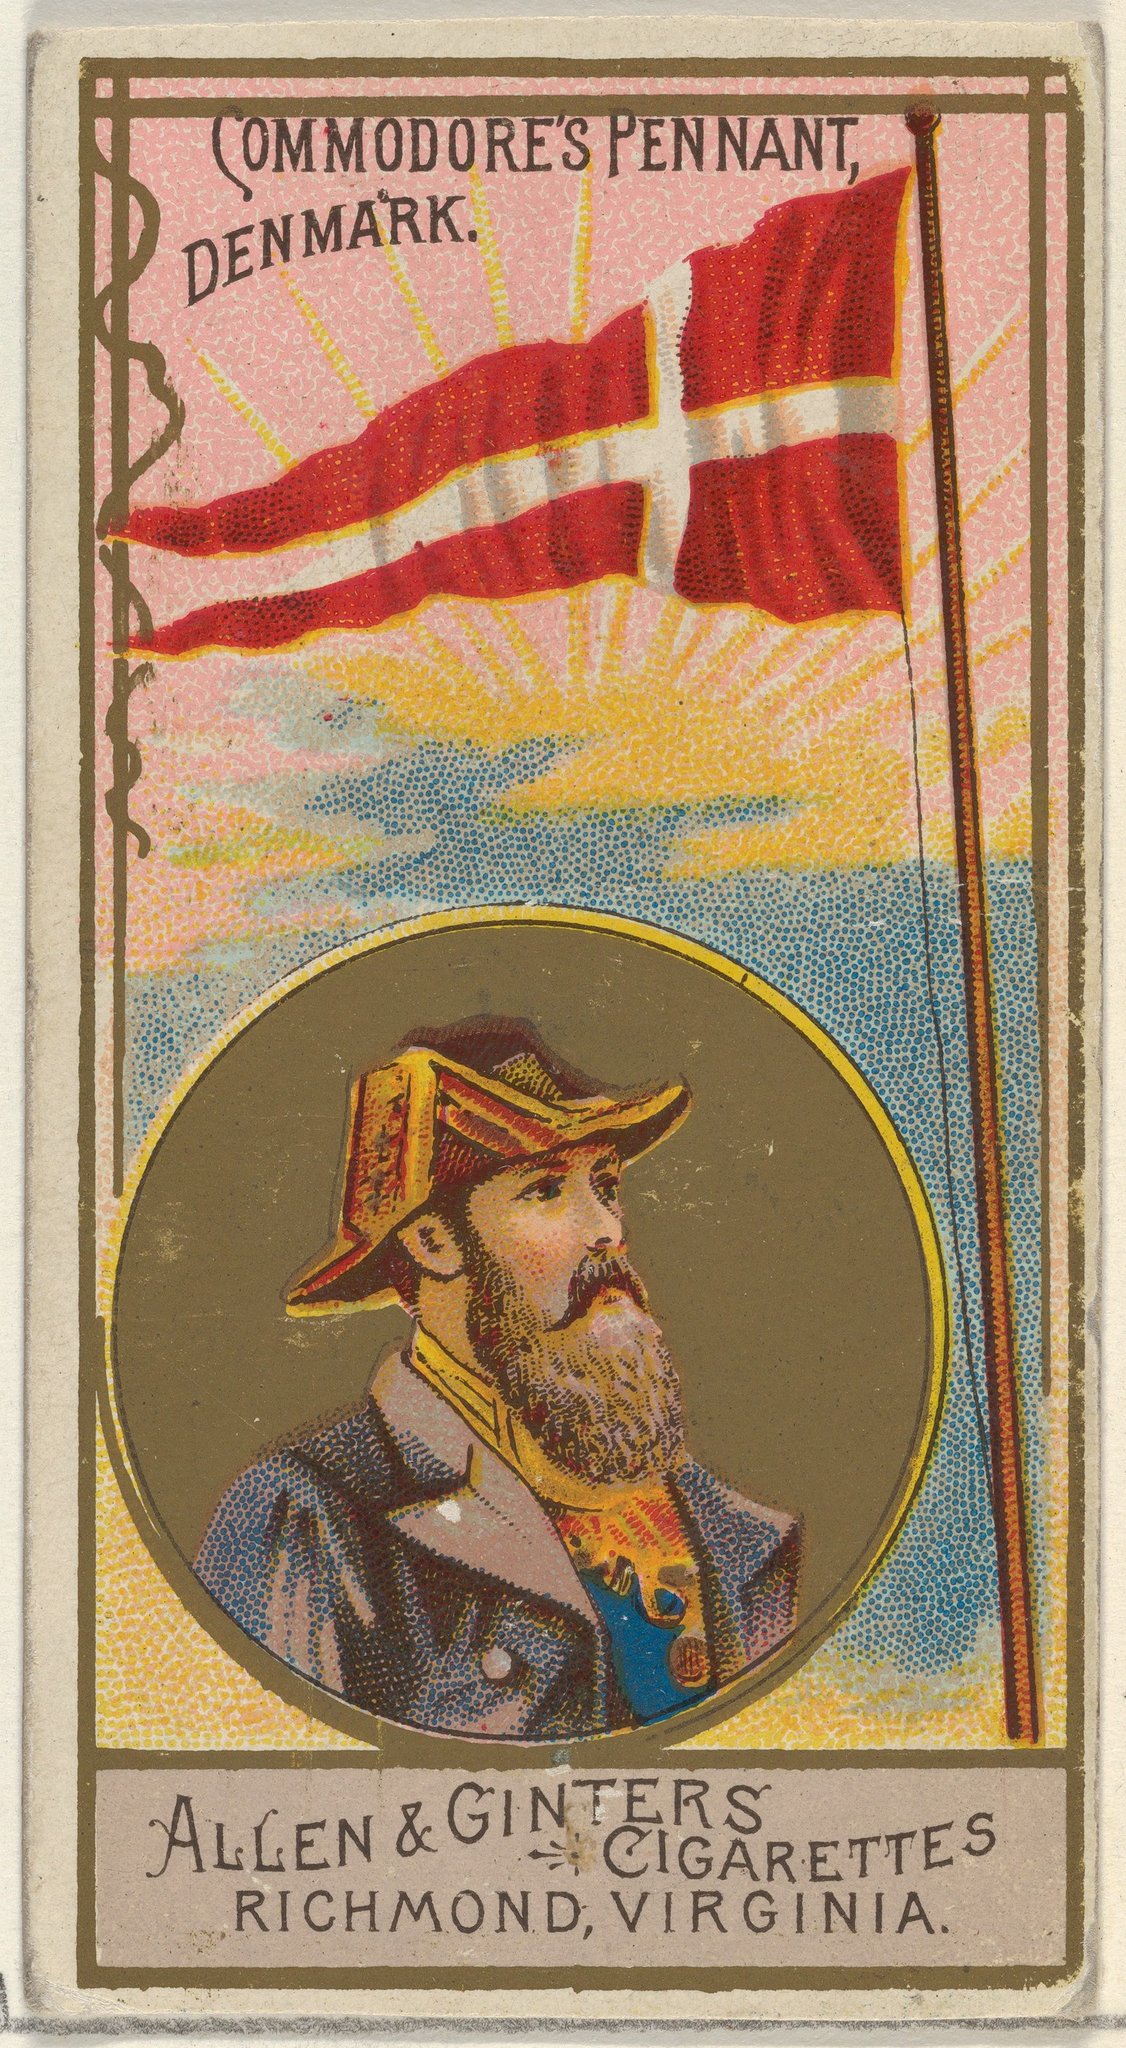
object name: print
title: Commodore's Pennant, Denmark, from the Naval Flags series (N17) for Allen & Ginter Cigarettes Brands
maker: allen & ginter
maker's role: publisher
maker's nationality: american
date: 1888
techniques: color lithograph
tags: men,flags